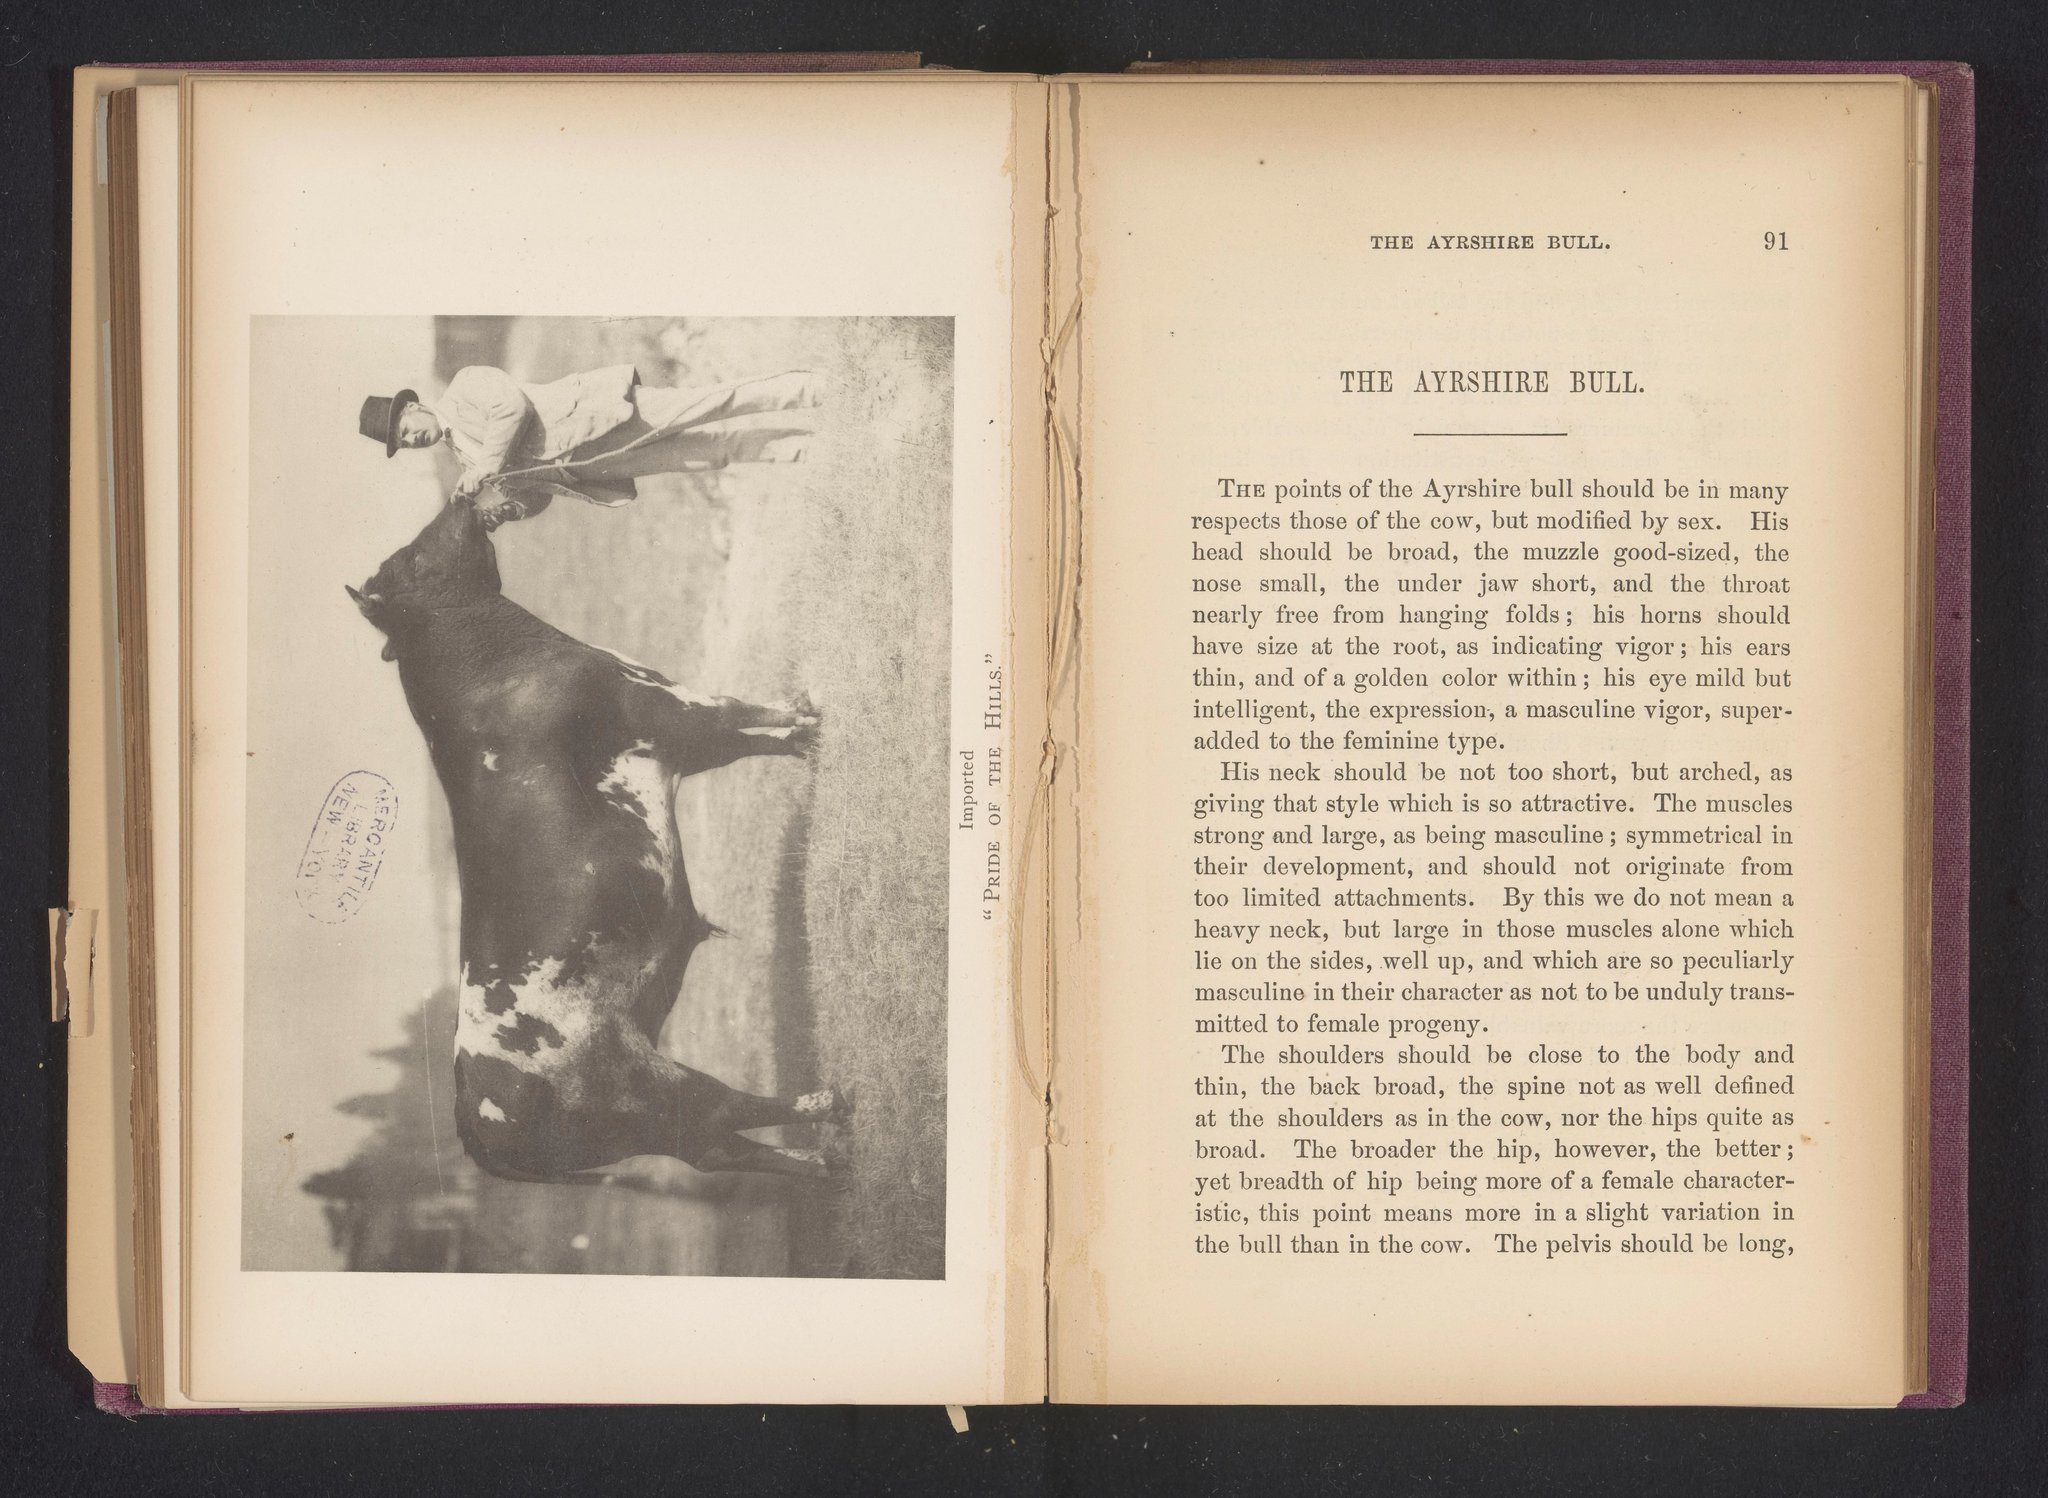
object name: photomechanical print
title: En profiel van een Ayrshire stier met boer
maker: Anonymous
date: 1875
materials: paper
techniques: photograph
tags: cow, farmers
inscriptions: collector's mark: ‘Mercantile Library New York’